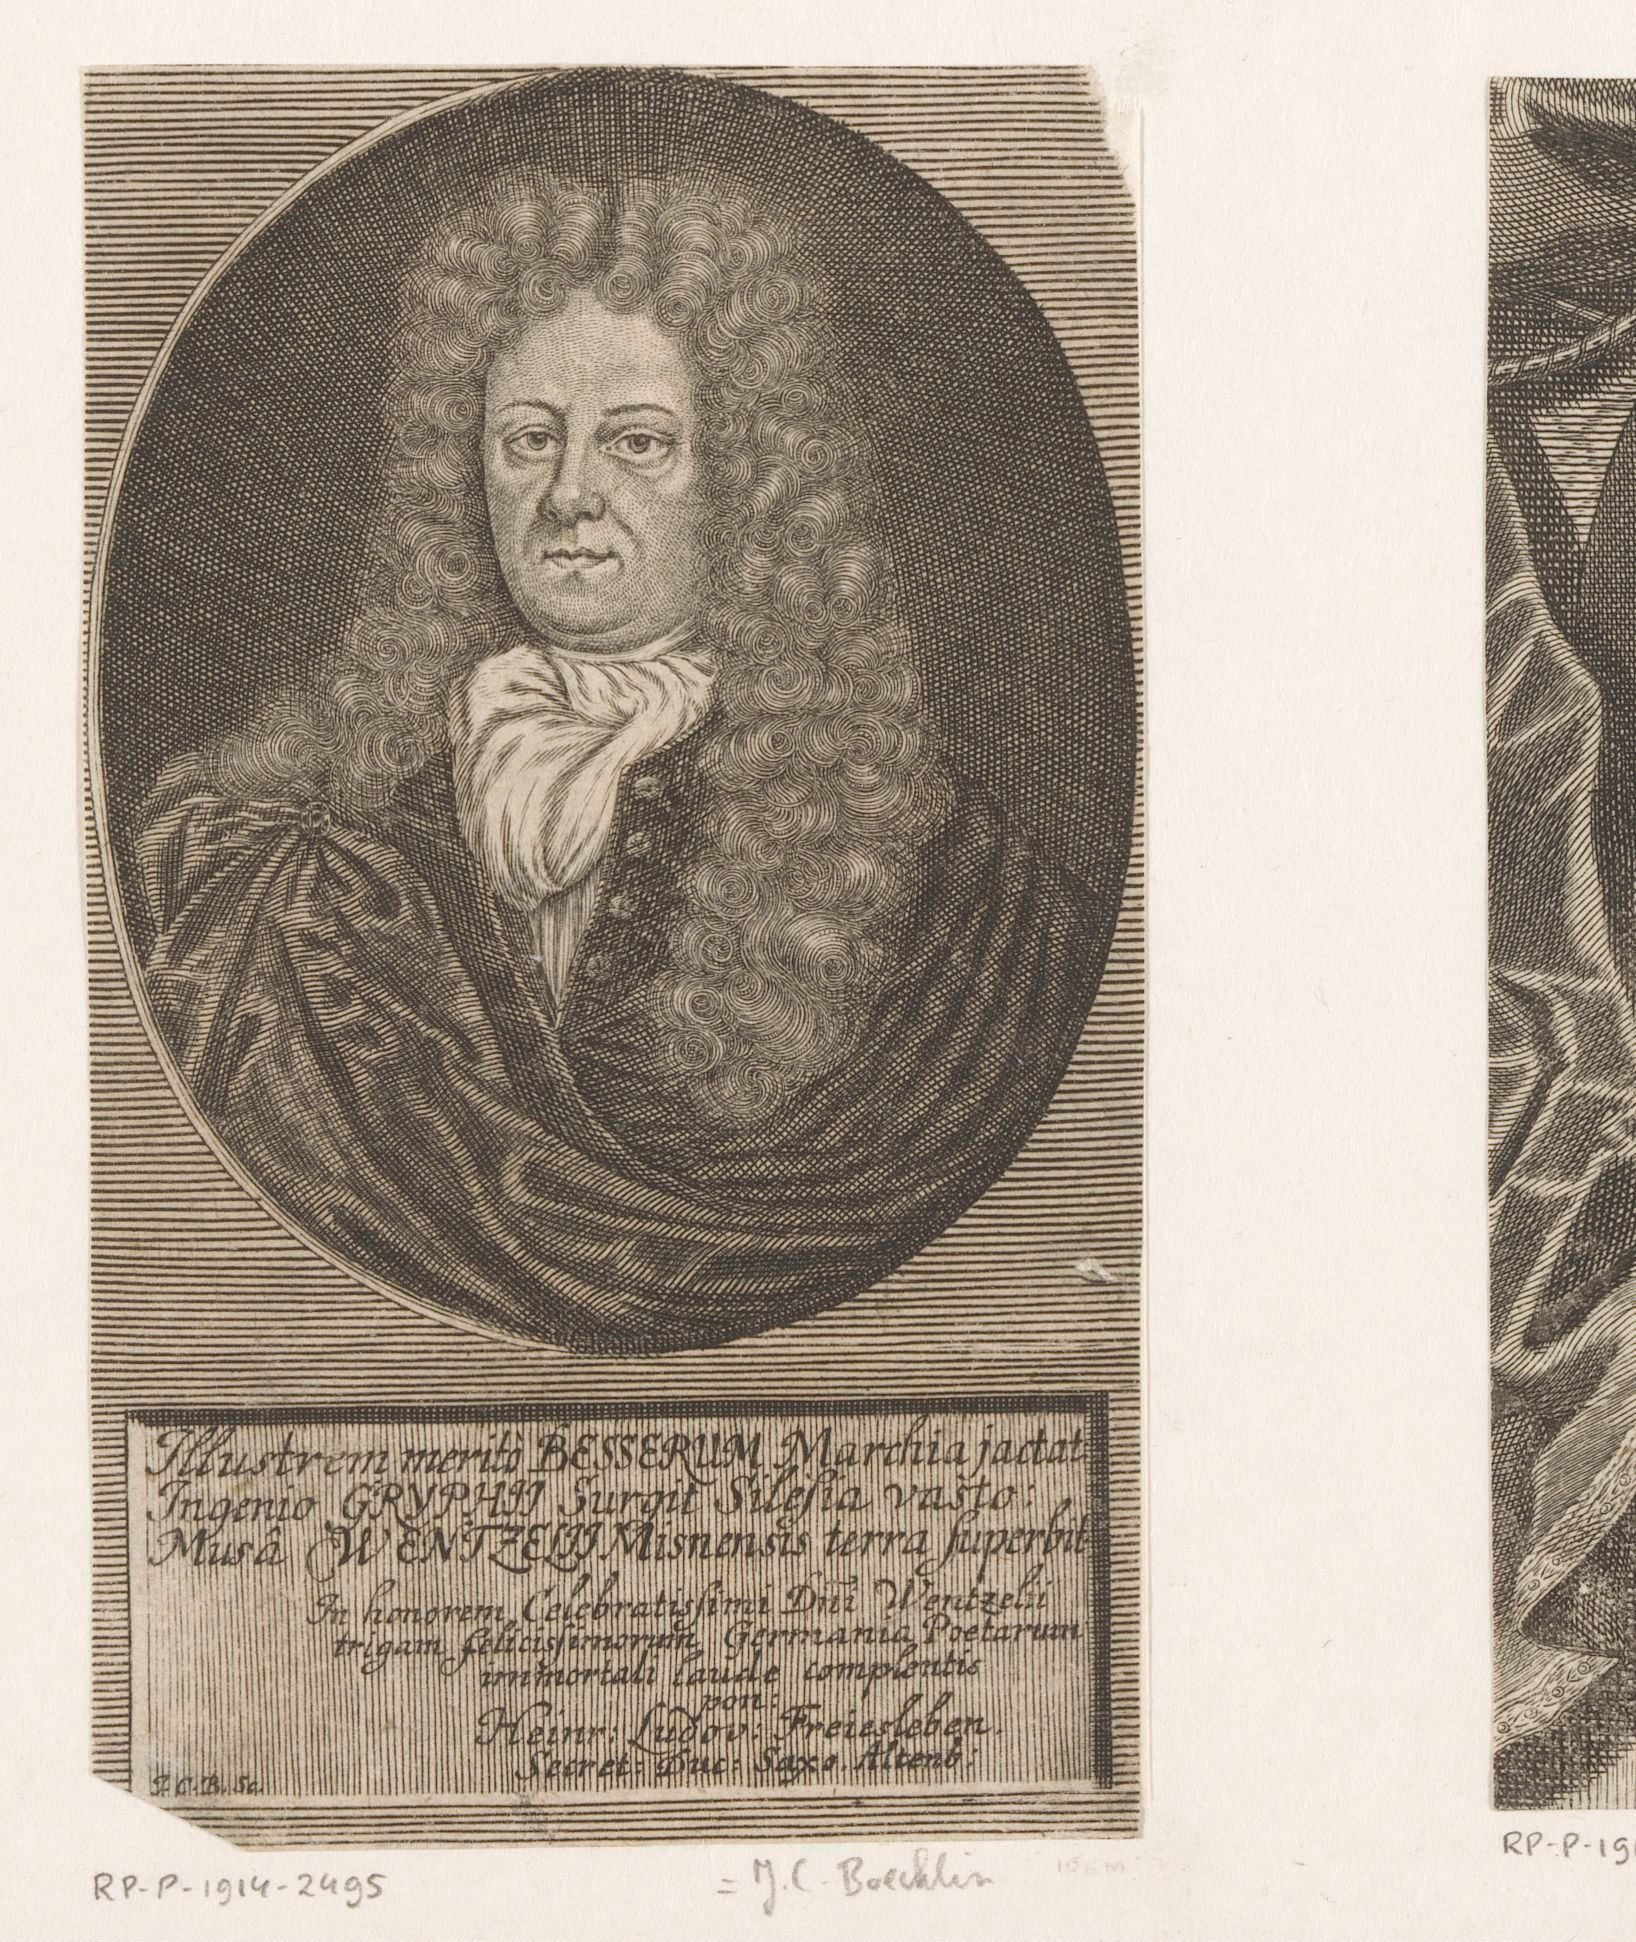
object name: print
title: Portret van Johann Christoph Wentzel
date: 1675-1709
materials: paper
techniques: engraving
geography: leipzig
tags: historical persons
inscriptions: collector's mark: Lugt 2228